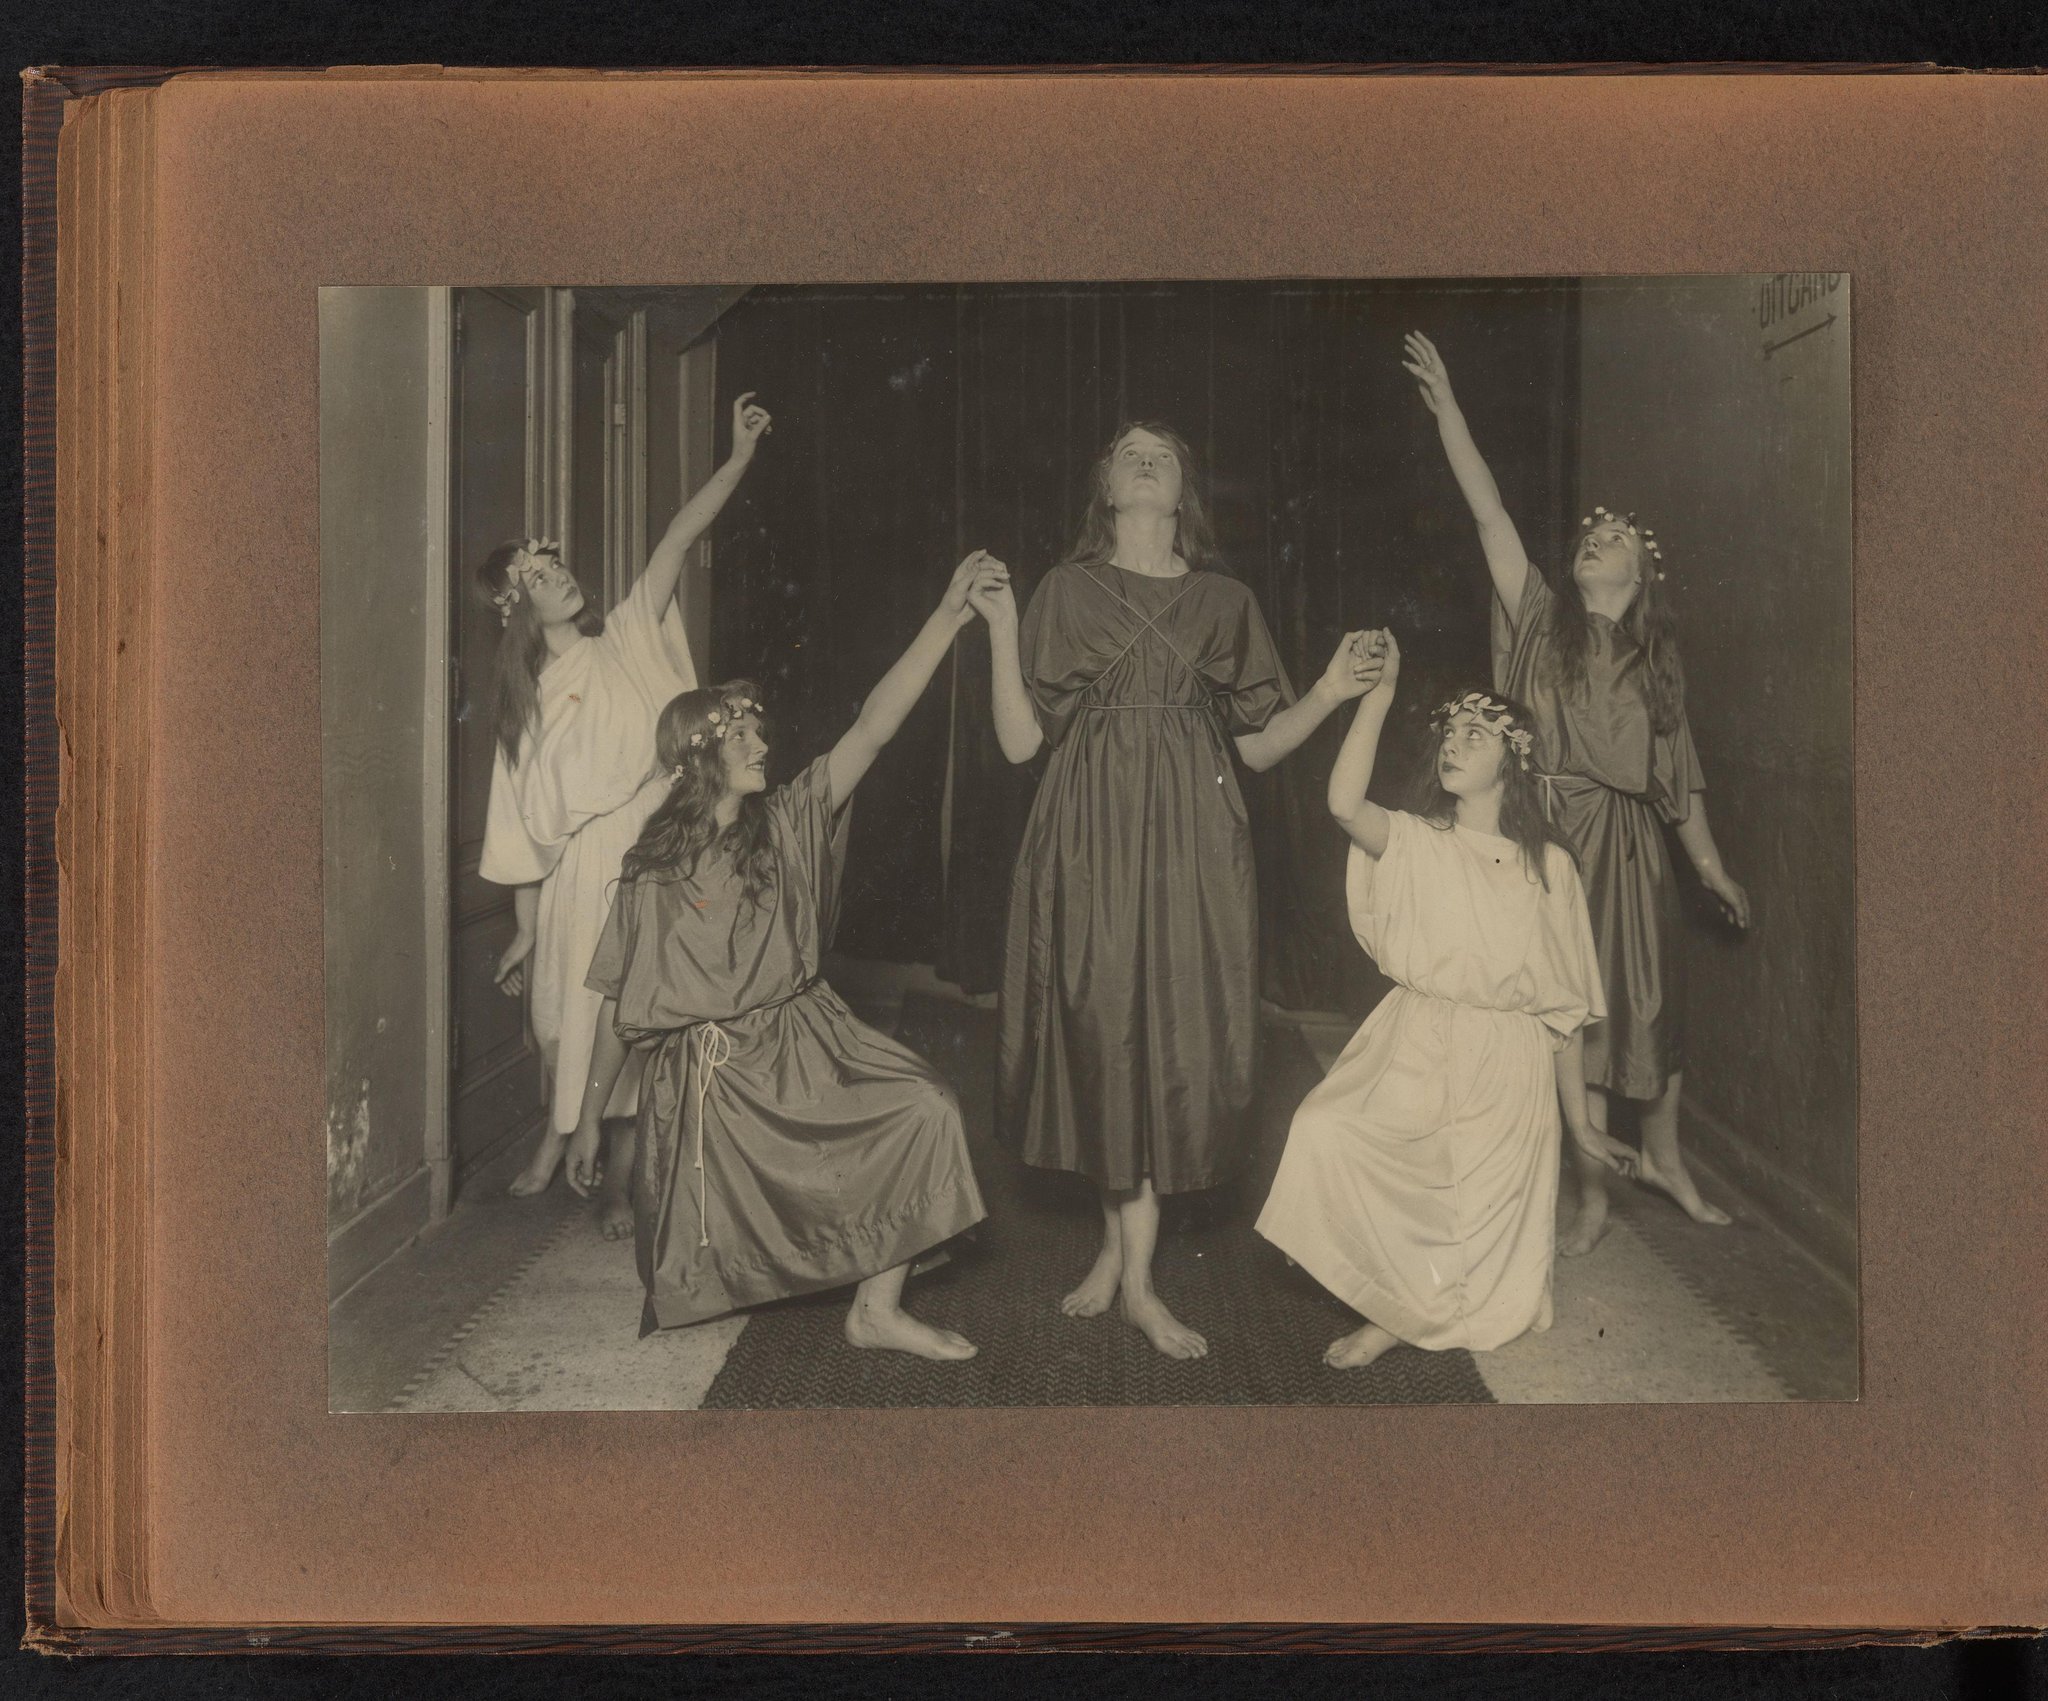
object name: photograph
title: Bladzijde uit het fotoalbum van de familie Diepenbrock met 1 foto met vijf jonge vrouwen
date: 1909-1920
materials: cardboard, photographic support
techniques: photography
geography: netherlands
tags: netherlands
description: Bruin albumblad 50 van familiealbum van Alphons Diepenbrock.